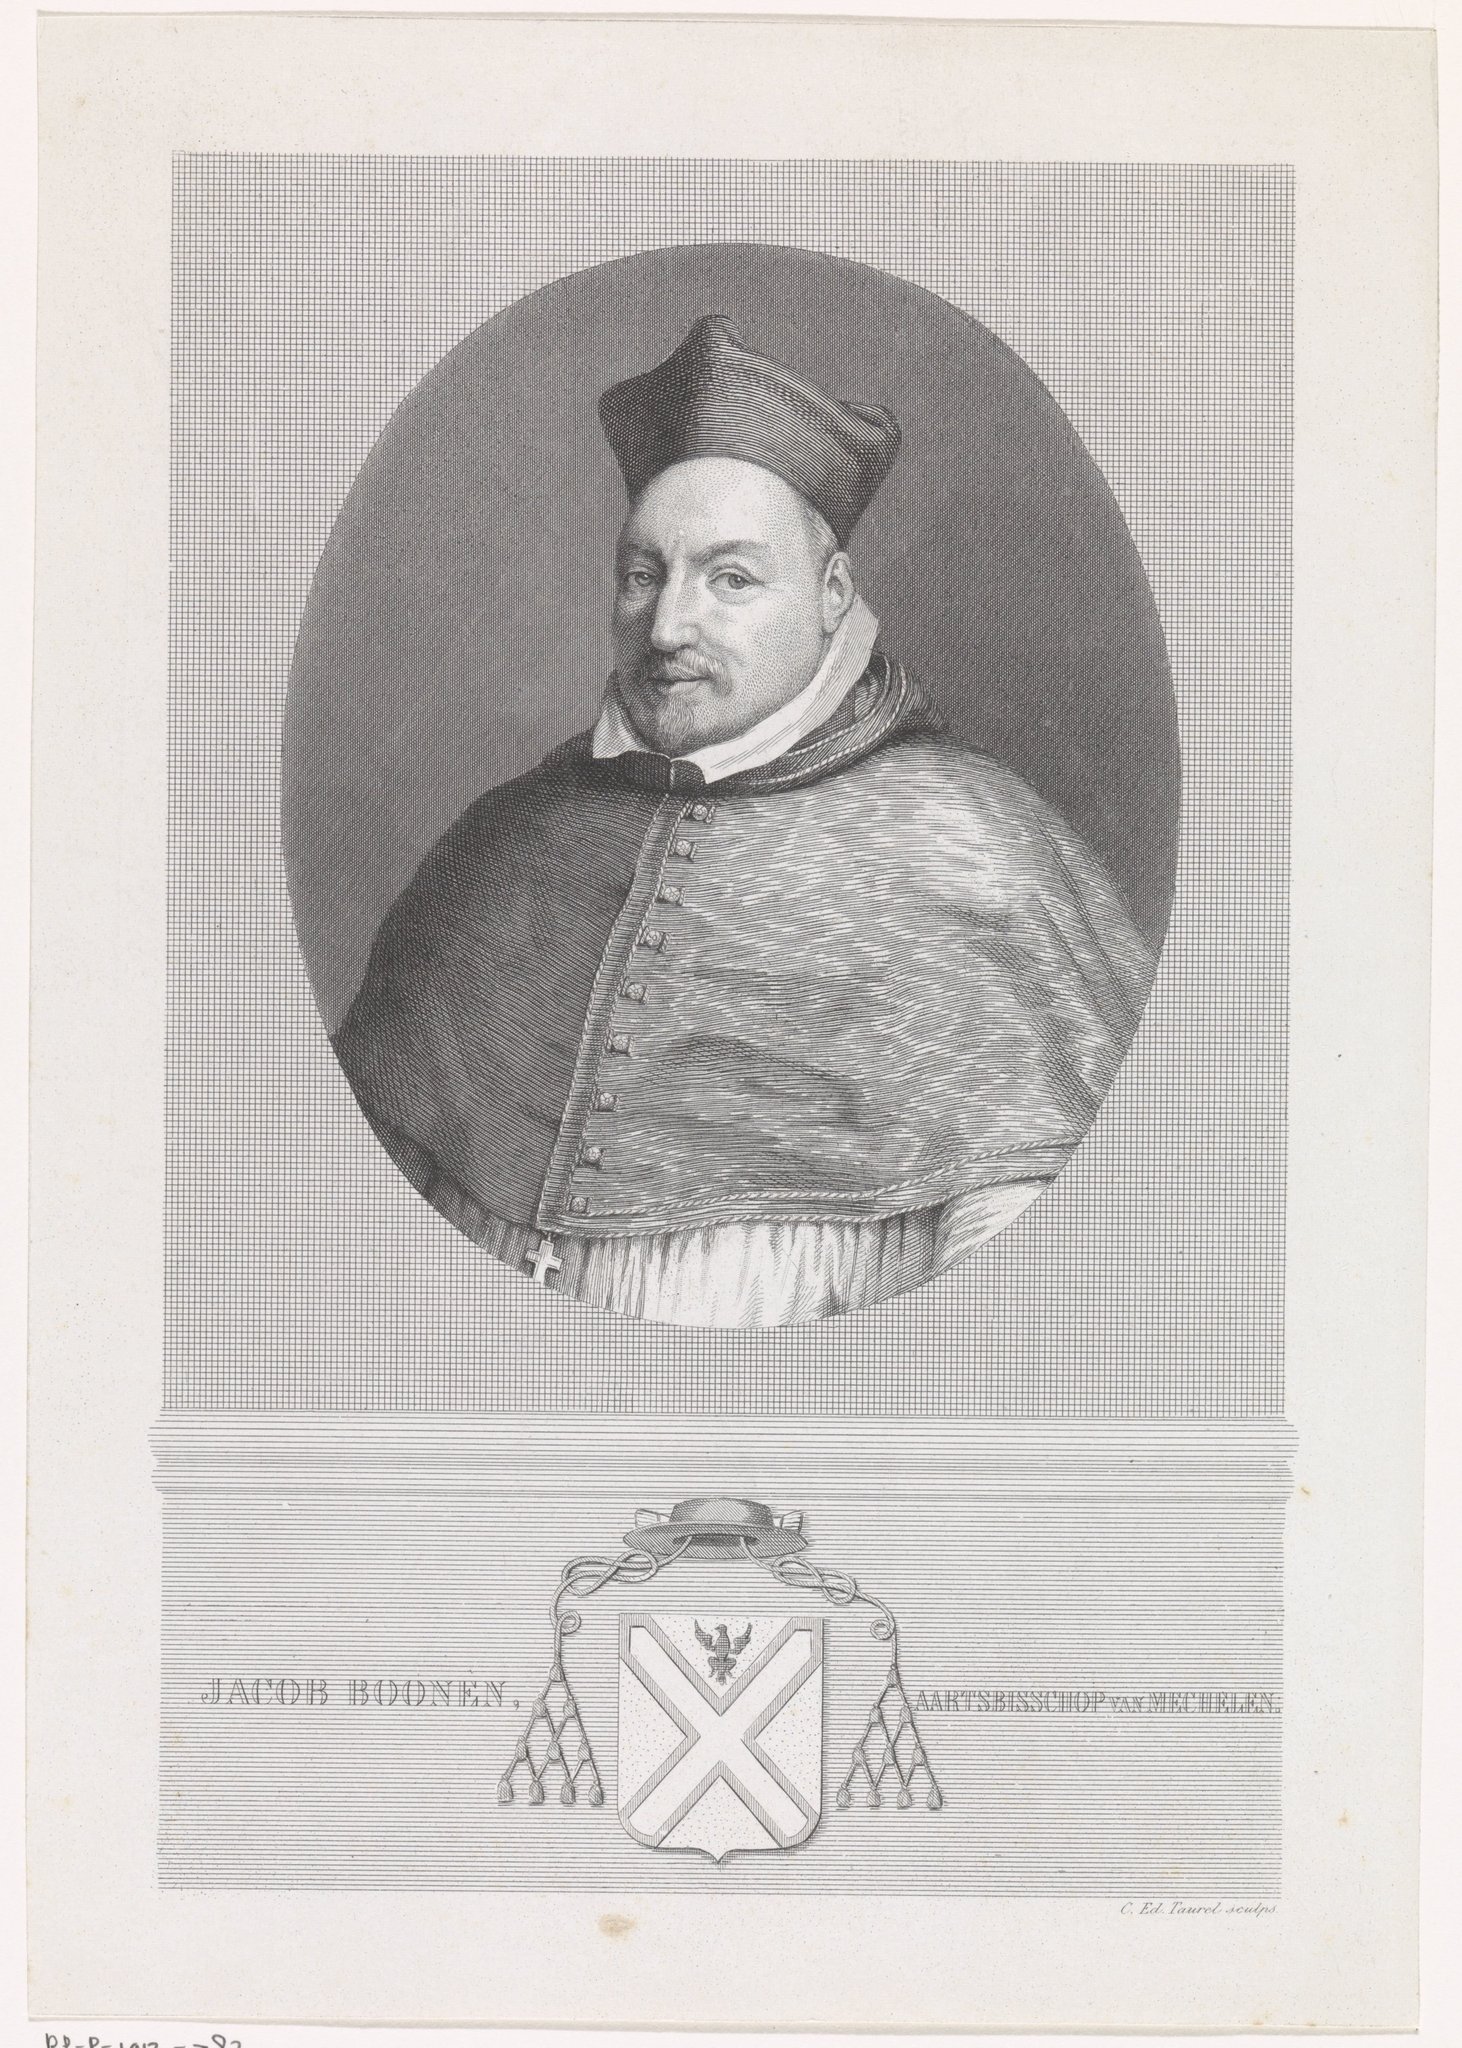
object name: print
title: Portret van Jacob Boonen, aartsbisschop van Mechelen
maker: edouard taurel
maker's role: draughtsman, print maker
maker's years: 1824-1892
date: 1841-1879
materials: paper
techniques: engraving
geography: amsterdam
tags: jacob boonen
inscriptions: collector's mark: Lugt 2228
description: Prent ook gebruikt als illustratie voor: Arend, Johannes Pieter. Algemeene geschiedenis des vaderlands van de vroegste tijden tot op heden. 5 delen. Amsterdam: J.F. Schleijer, 1841-1884. dl. III.4, p. 646.